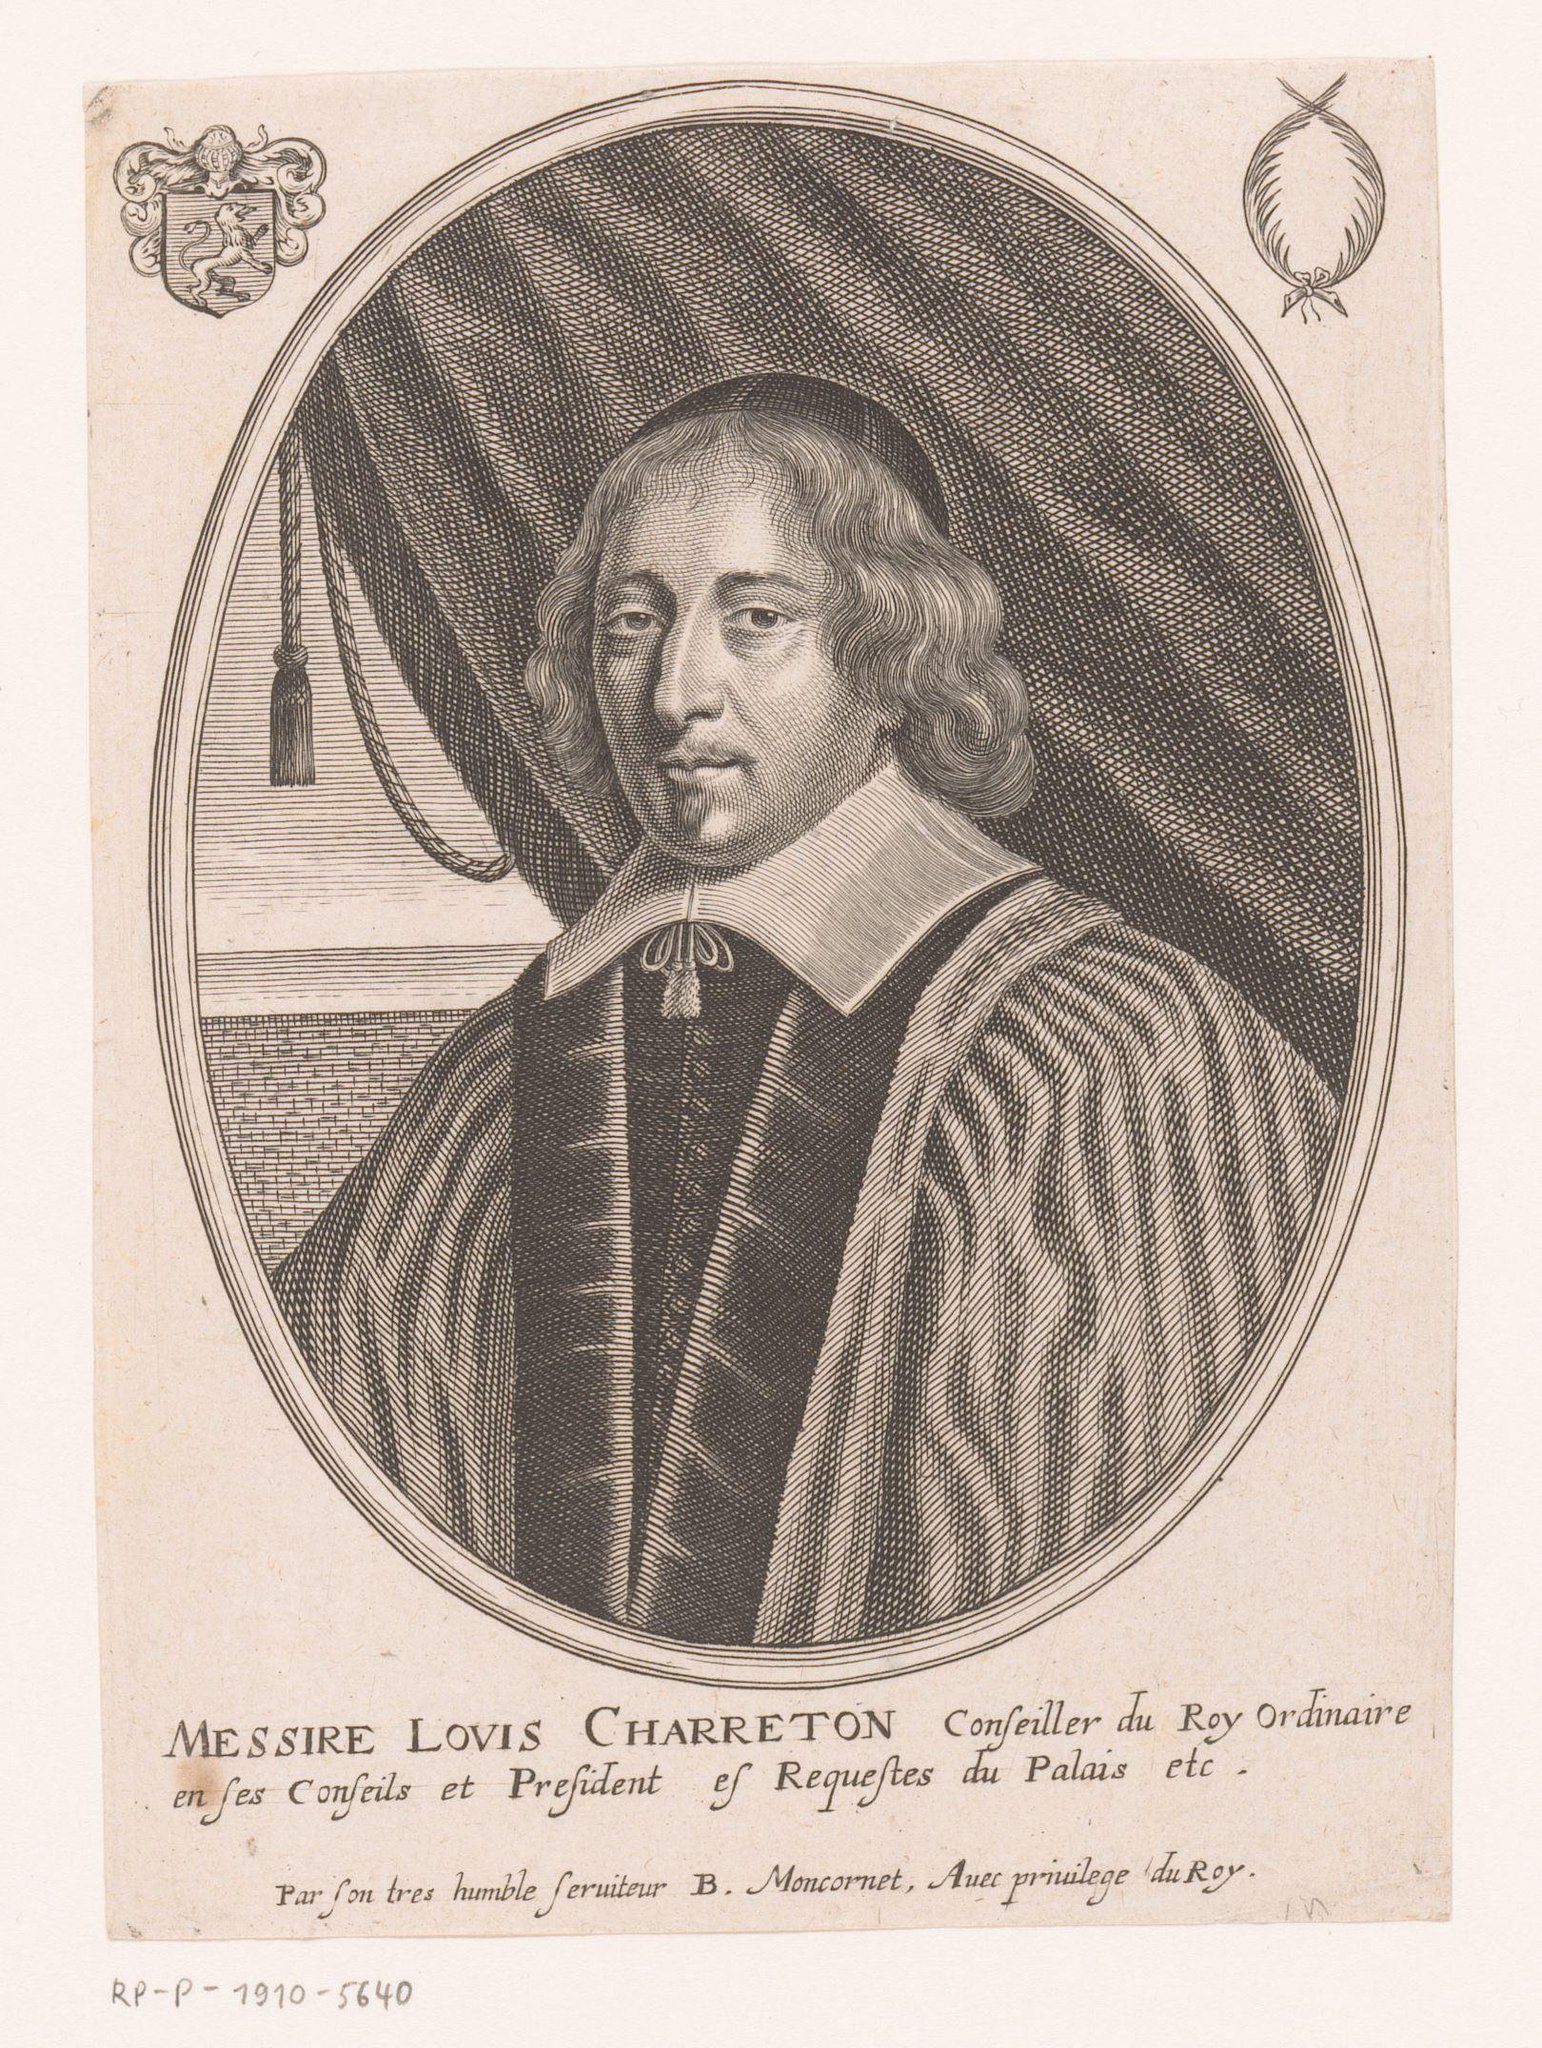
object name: print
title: Portret van Louis Charreton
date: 1610-1668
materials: paper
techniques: engraving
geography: paris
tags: official; civil servant; functionary (in general), historical persons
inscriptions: collector's mark: Lugt 2228